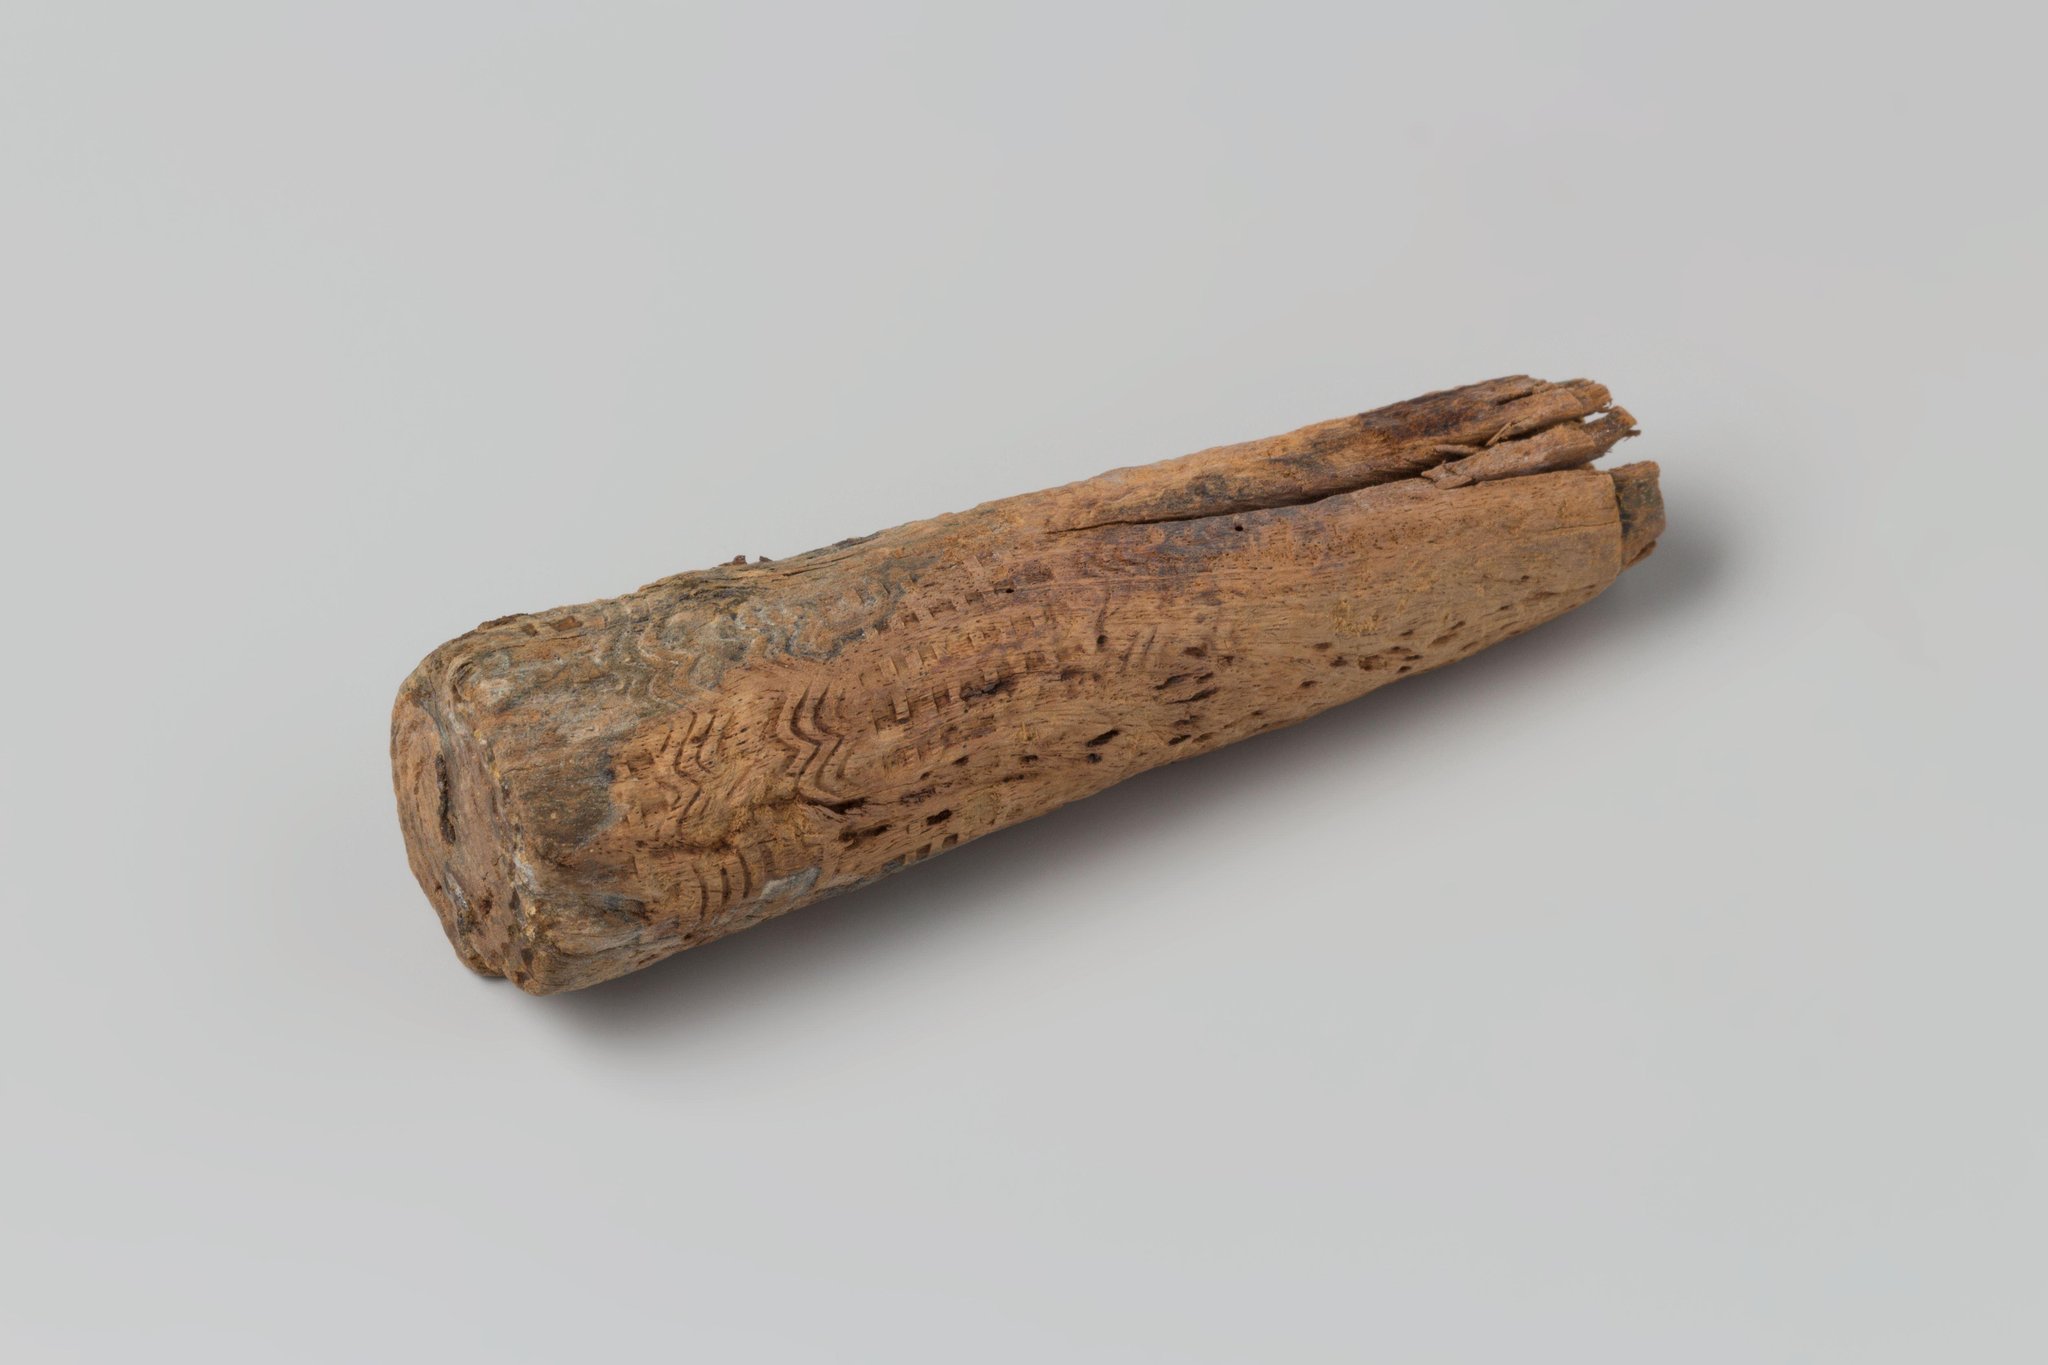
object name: knife handle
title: Messenheft uit het wrak van de Oost-Indiëvaarder Hollandia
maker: Anonymous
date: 1700-1743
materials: wood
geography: netherlands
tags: verenigde oostindische compagnie, hollandia (schip), annet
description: Knife, handle, cylindrical: tapering; id. NG 1979-403H, ferrules, id. NG 1980-27H426.